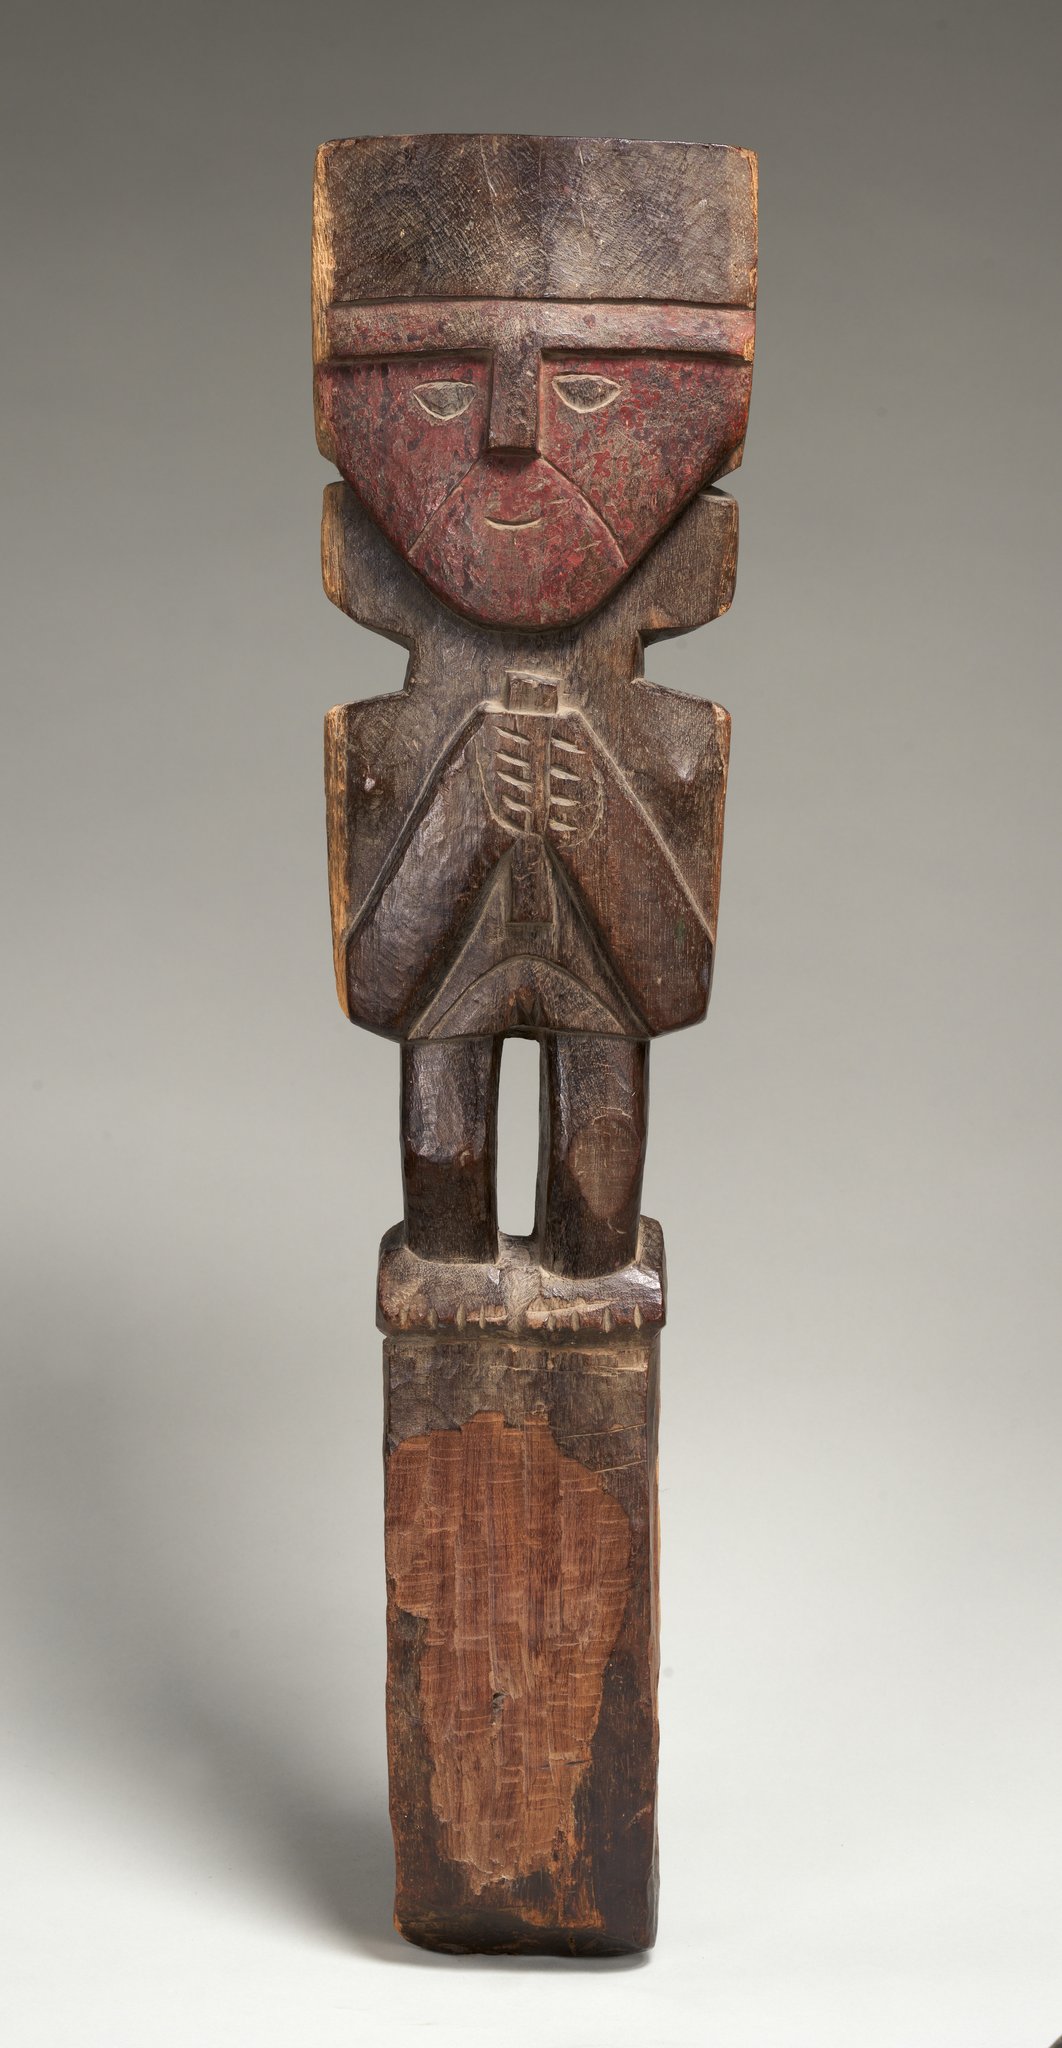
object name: figure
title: Standing female figure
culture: chimú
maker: chimú artist(s)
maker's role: artist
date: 1350-1470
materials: pigment, wood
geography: peru